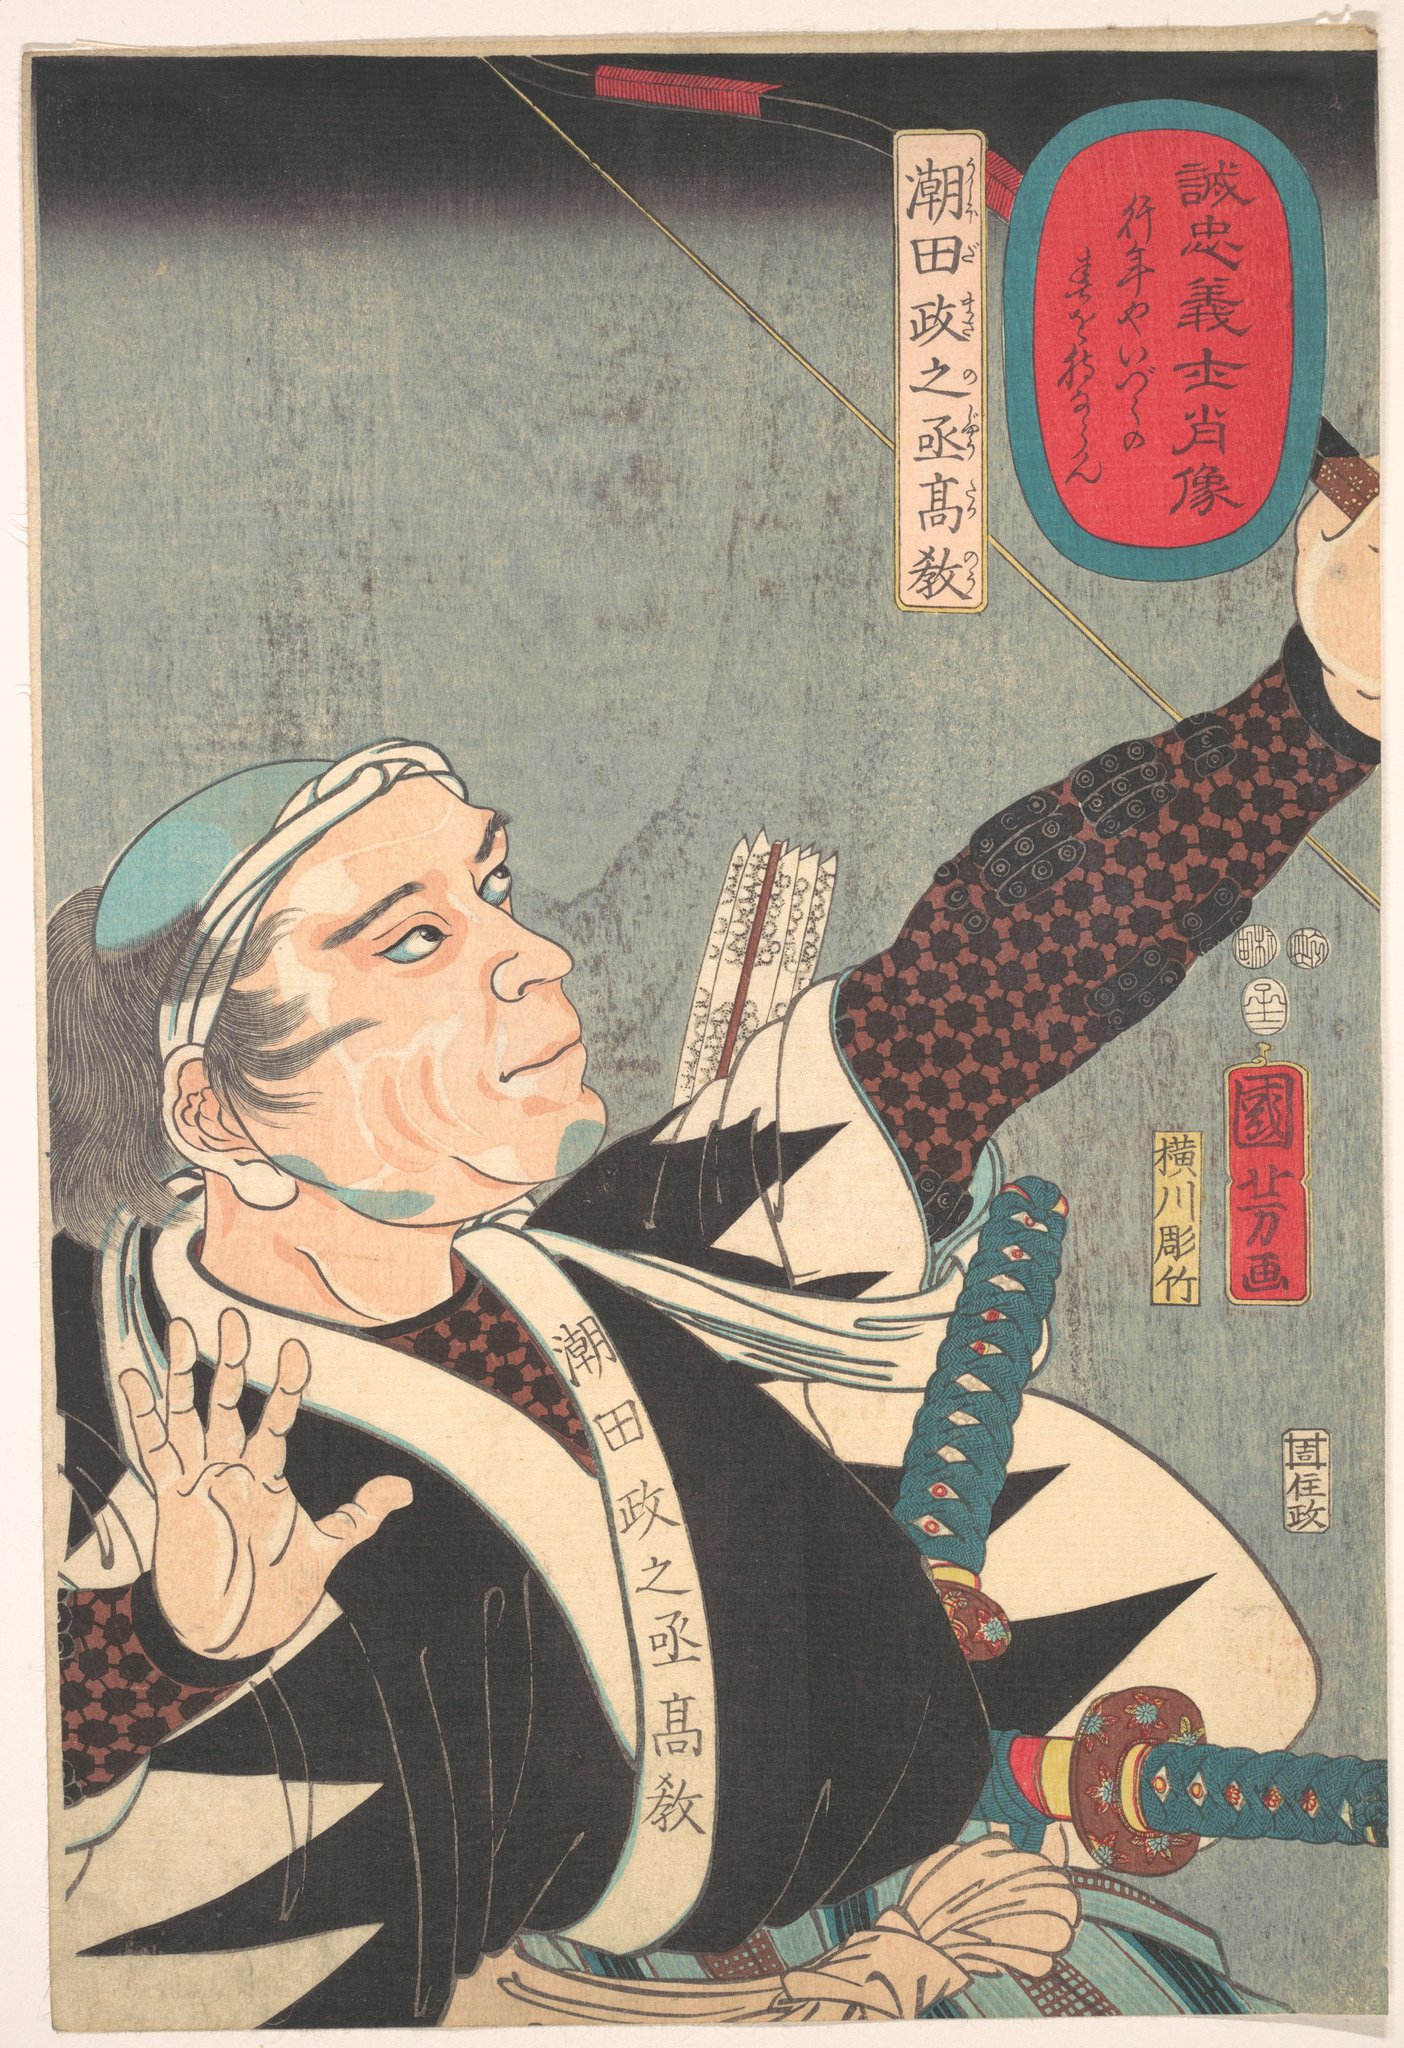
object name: print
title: Portrait of Ushioda Masanojo Takano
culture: japanese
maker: utagawa kuniyoshi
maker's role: artist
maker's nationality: japanese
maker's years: 1797-1861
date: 1852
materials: ink, paper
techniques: woodblock print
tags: bow and arrow,men,portraits